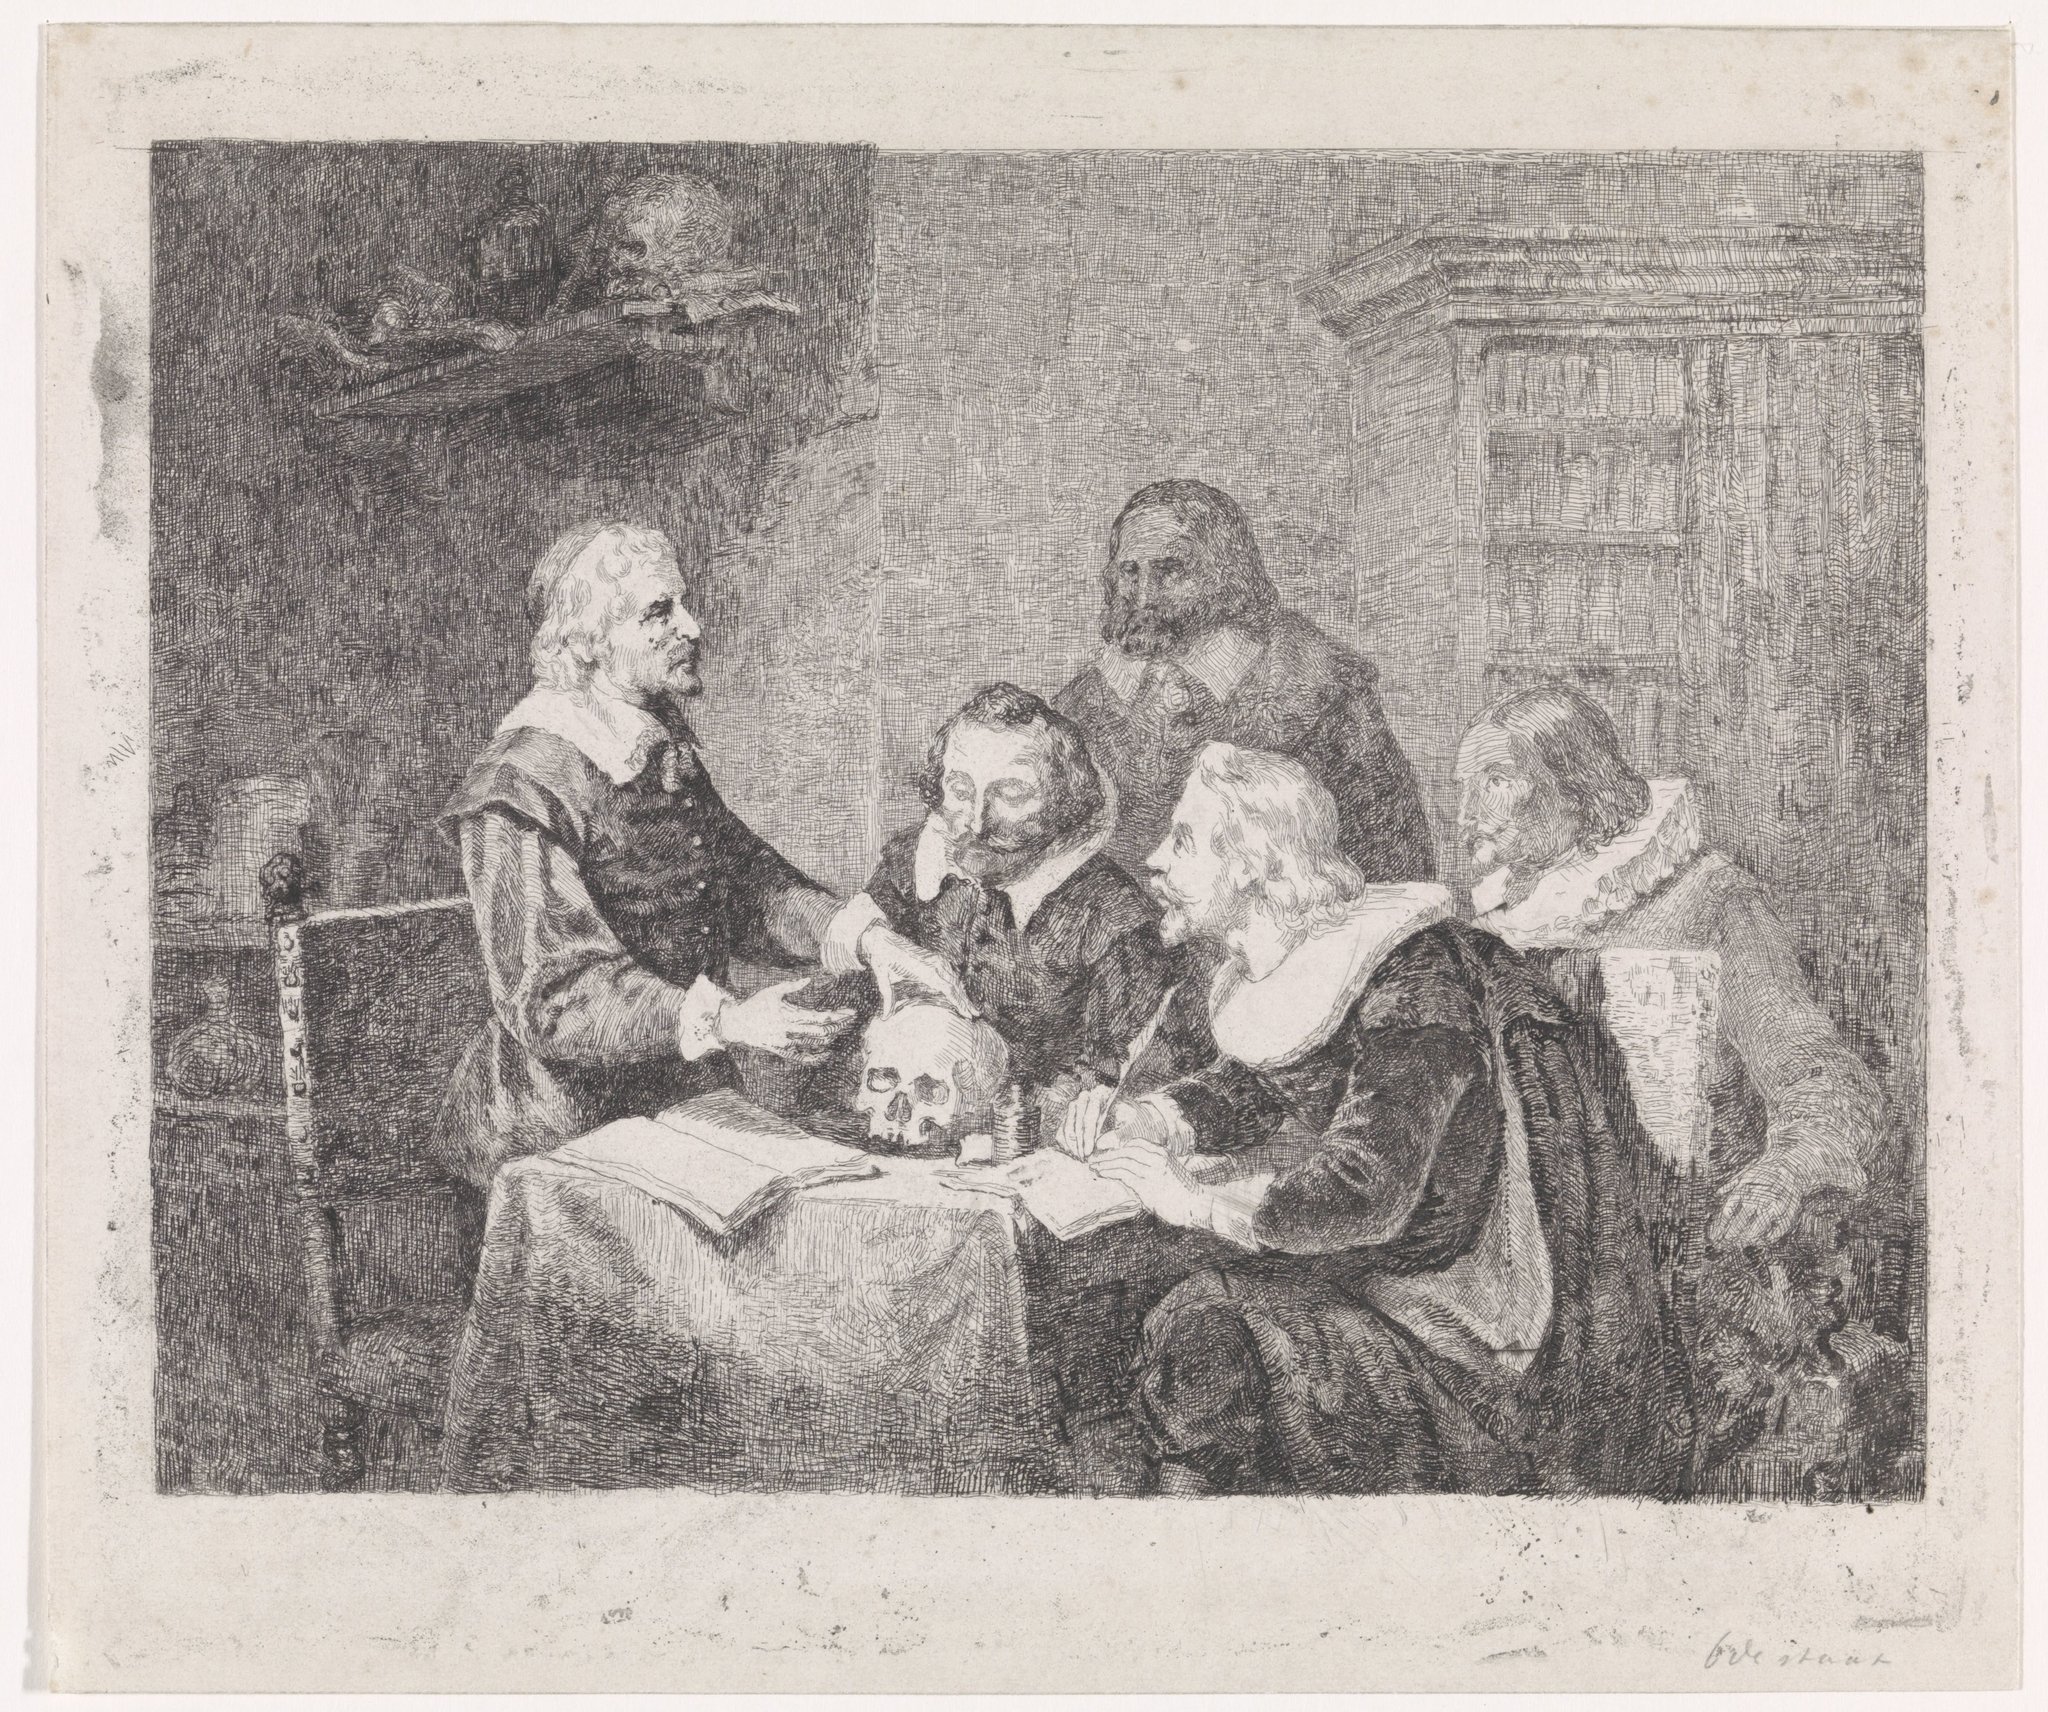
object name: print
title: Anatomische les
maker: david van der kellen (1827-1895)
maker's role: draughtsman, print maker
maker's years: 1827-1895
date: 1837-1882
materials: paper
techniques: drypoint, etching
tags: (human) skull, teacher and pupil, writing accessories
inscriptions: collector's mark: Lugt 2228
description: In een studeerkamer geeft een geleerde anatomische les aan zijn leerlingen. De leermeester staat voor de tafel, waaraan zijn vier studenten zitten, en legt iets uit over de schedel die hij onder zijn linkerhand houdt. Een van de leerlingen maakt met een schrijfveer aantekeningen. Zowel de leermeester als de pupillen zijn gehuld in zeventiende-eeuwse kleding. Op de achtergrond staat een boekenkast en op de plank aan de muur staan onder andere een schedel en een fles.